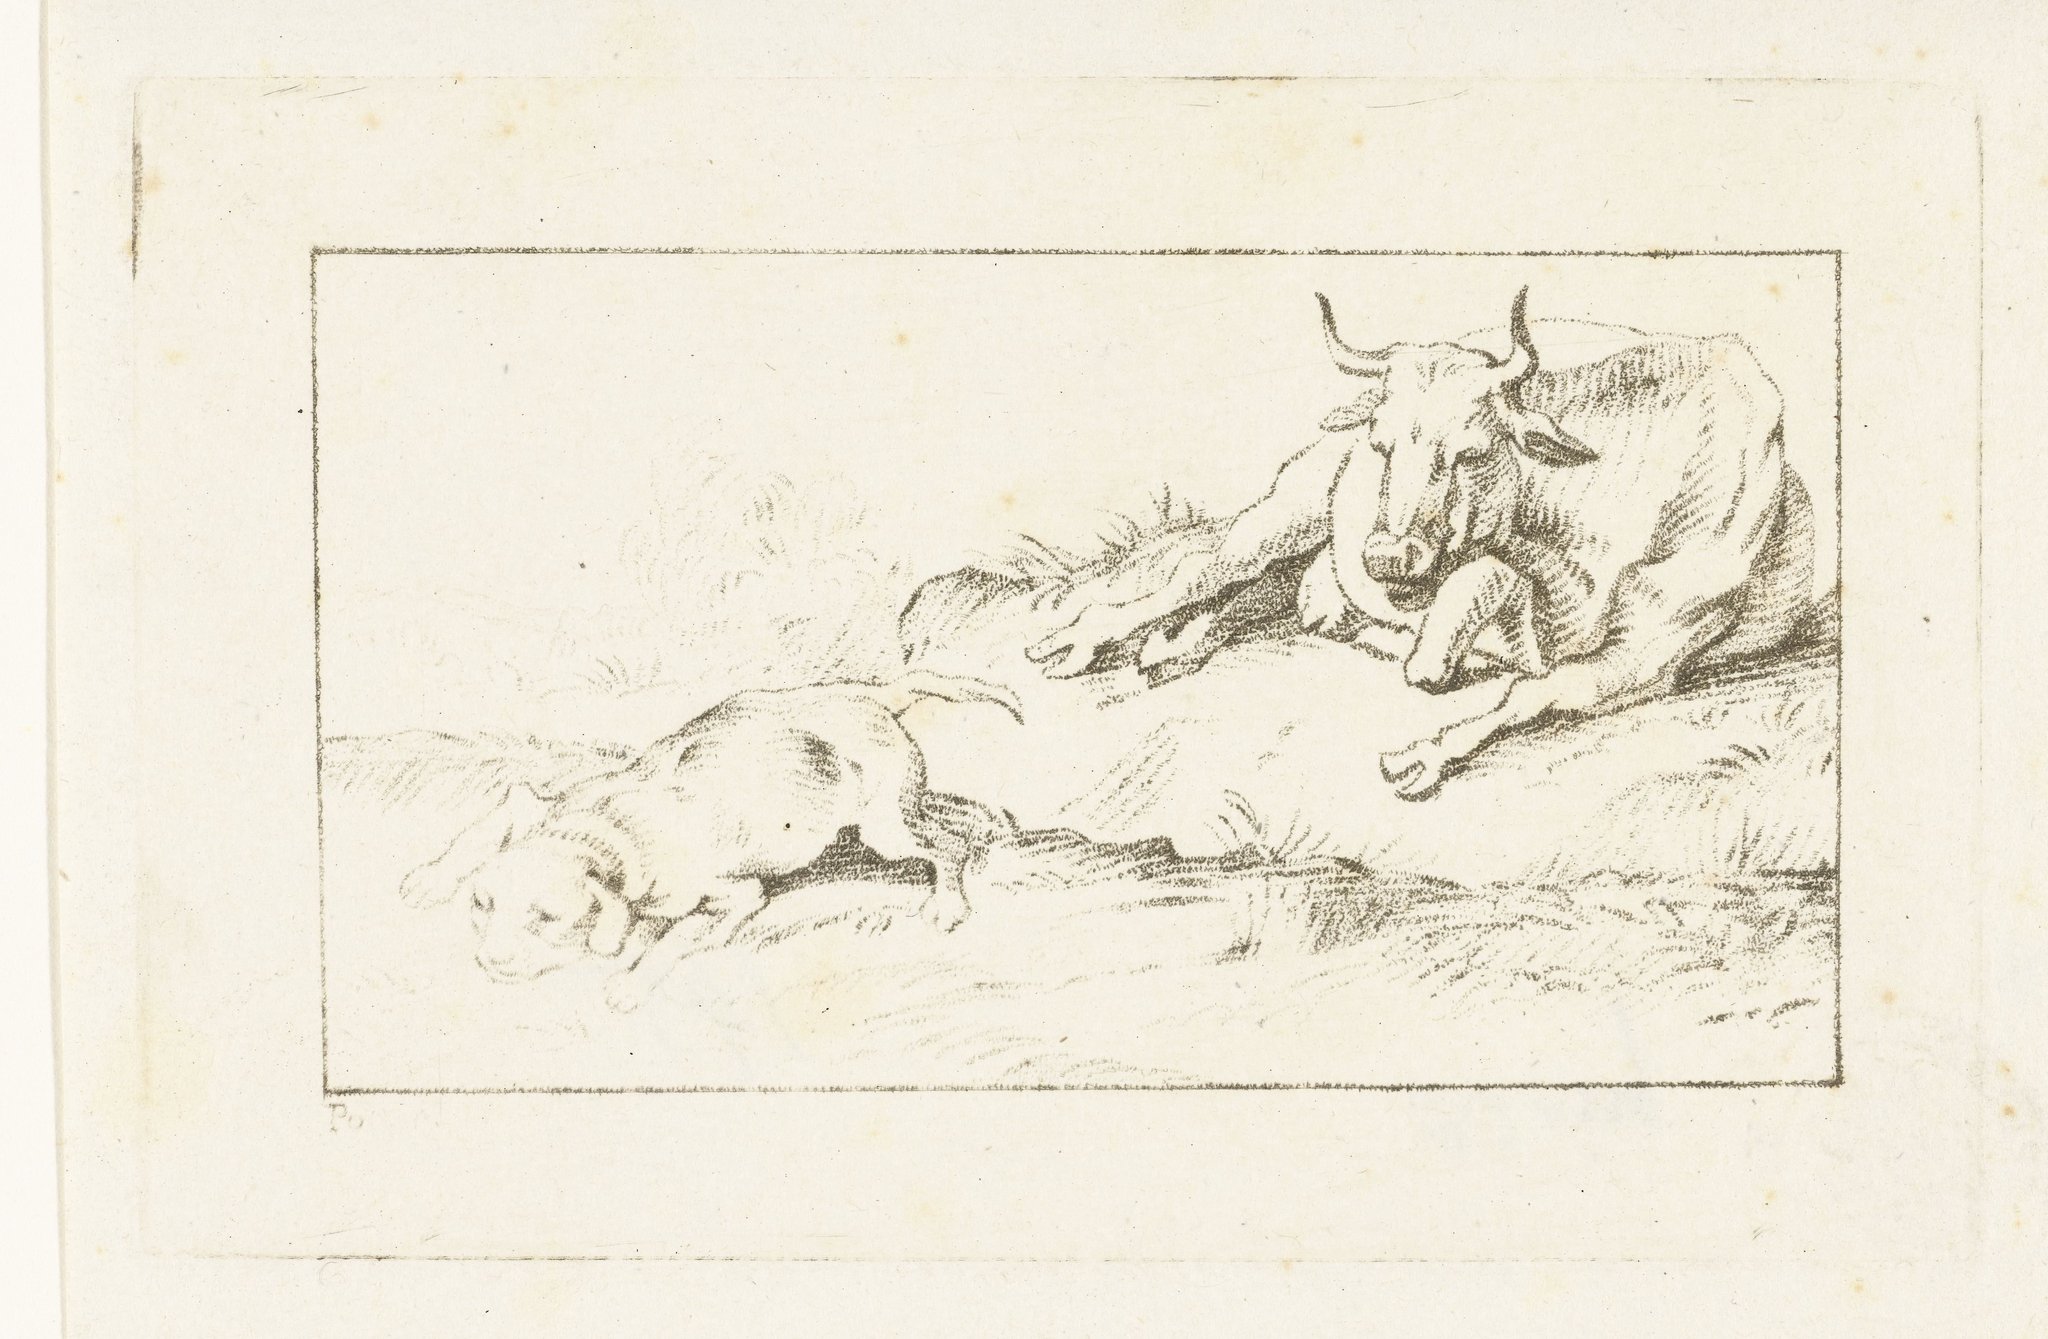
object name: print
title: Koe en hond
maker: jacobus buys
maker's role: draughtsman, print maker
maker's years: 1724-1801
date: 1740-1801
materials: paper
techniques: printmaking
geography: amsterdam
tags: dog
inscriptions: collector's mark: Lugt 240